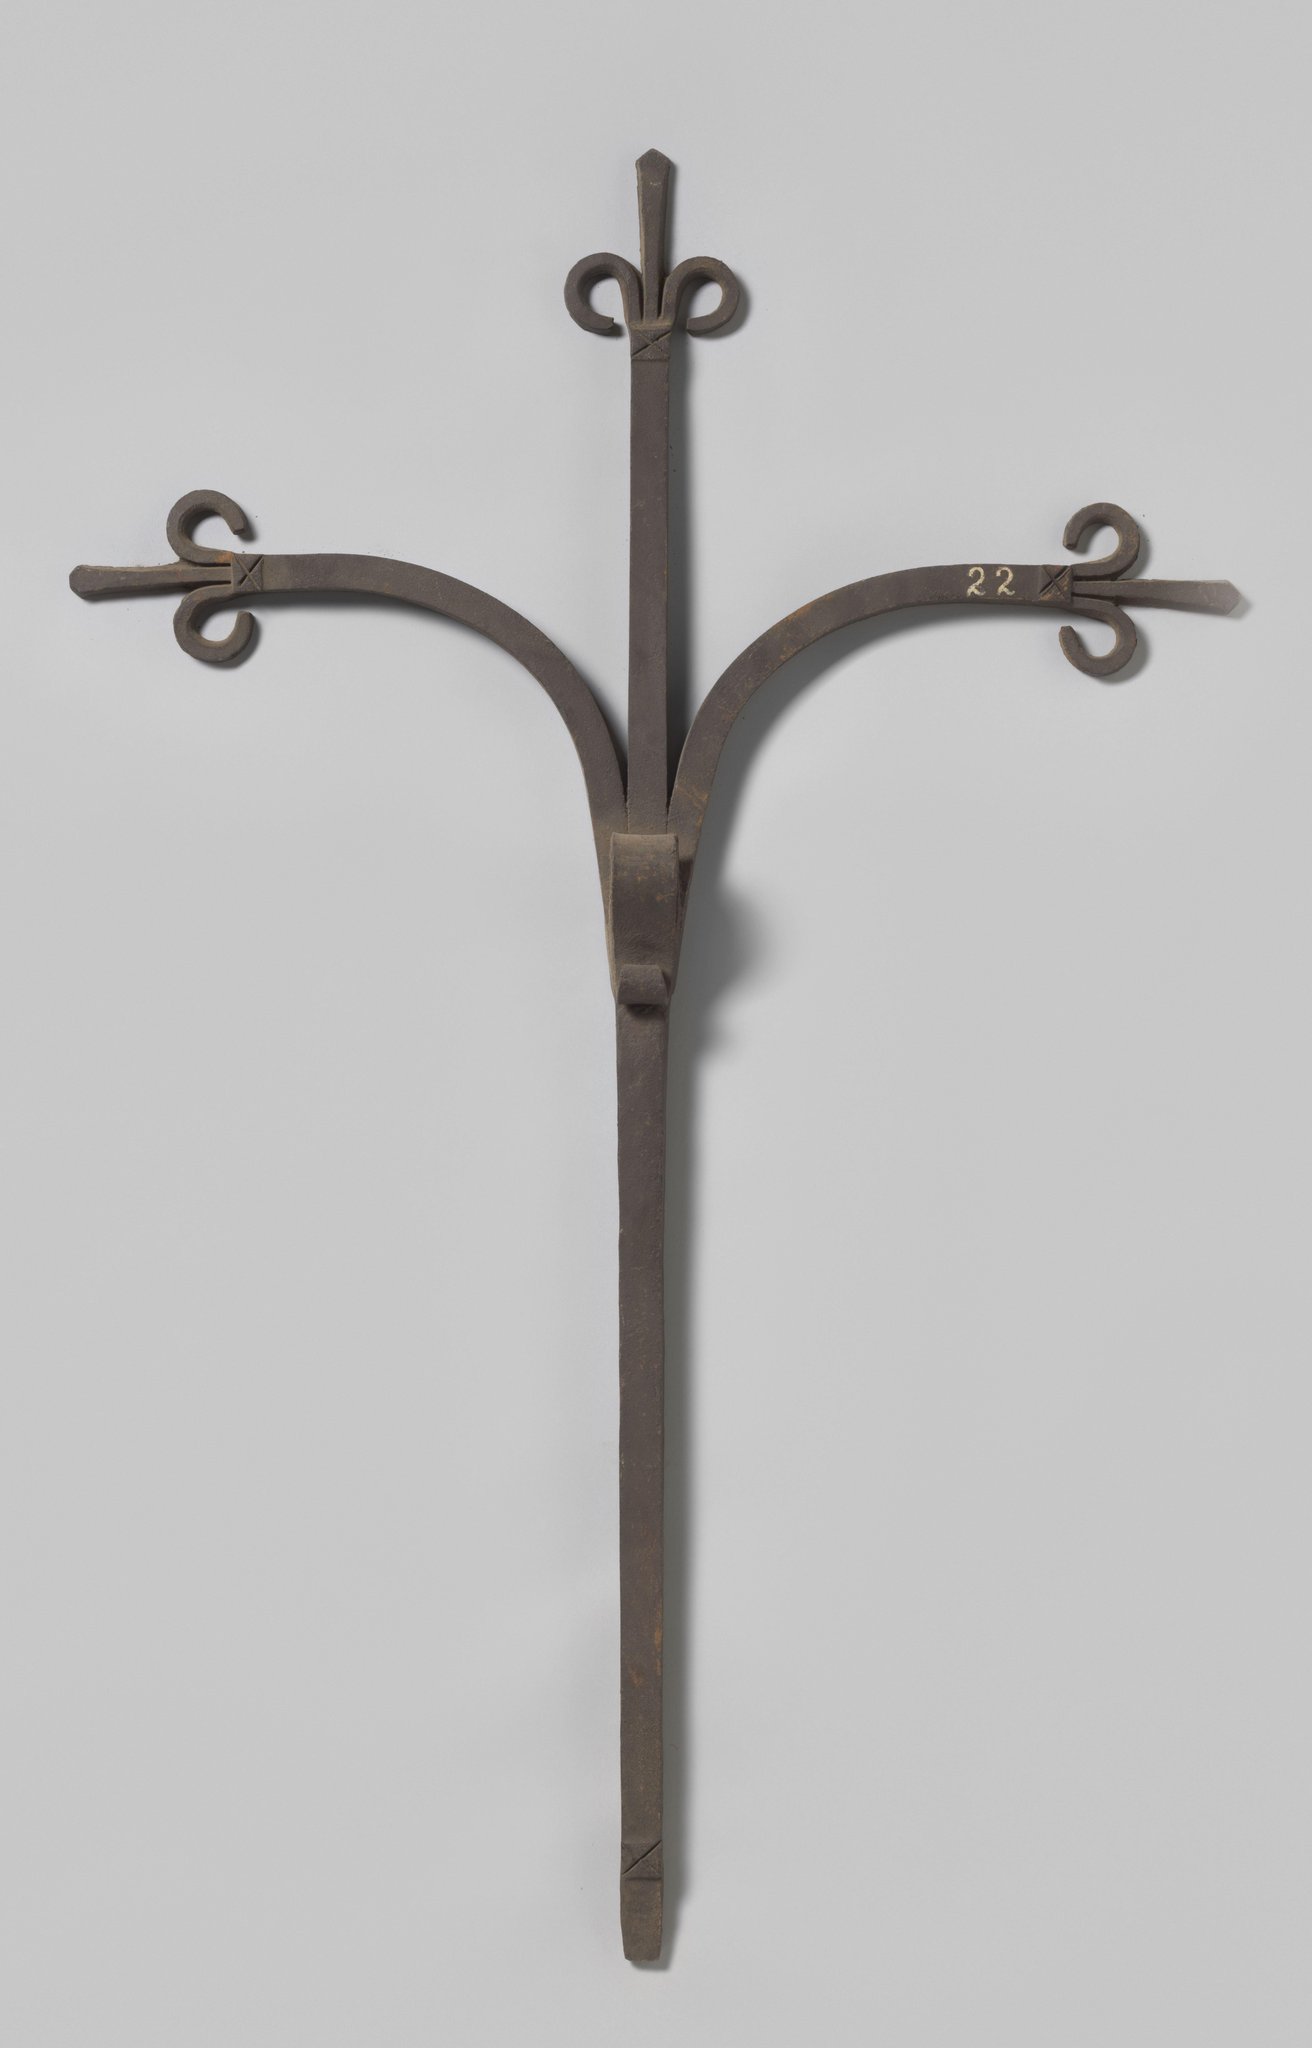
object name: schieter, schoter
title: Muuranker van het Gelderse Spijker te Arnhem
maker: Anonymous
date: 1500-1600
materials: iron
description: Muuranker, afkomstig van het Gelderse Spijker te Arnhem. gesloopt in 1880.